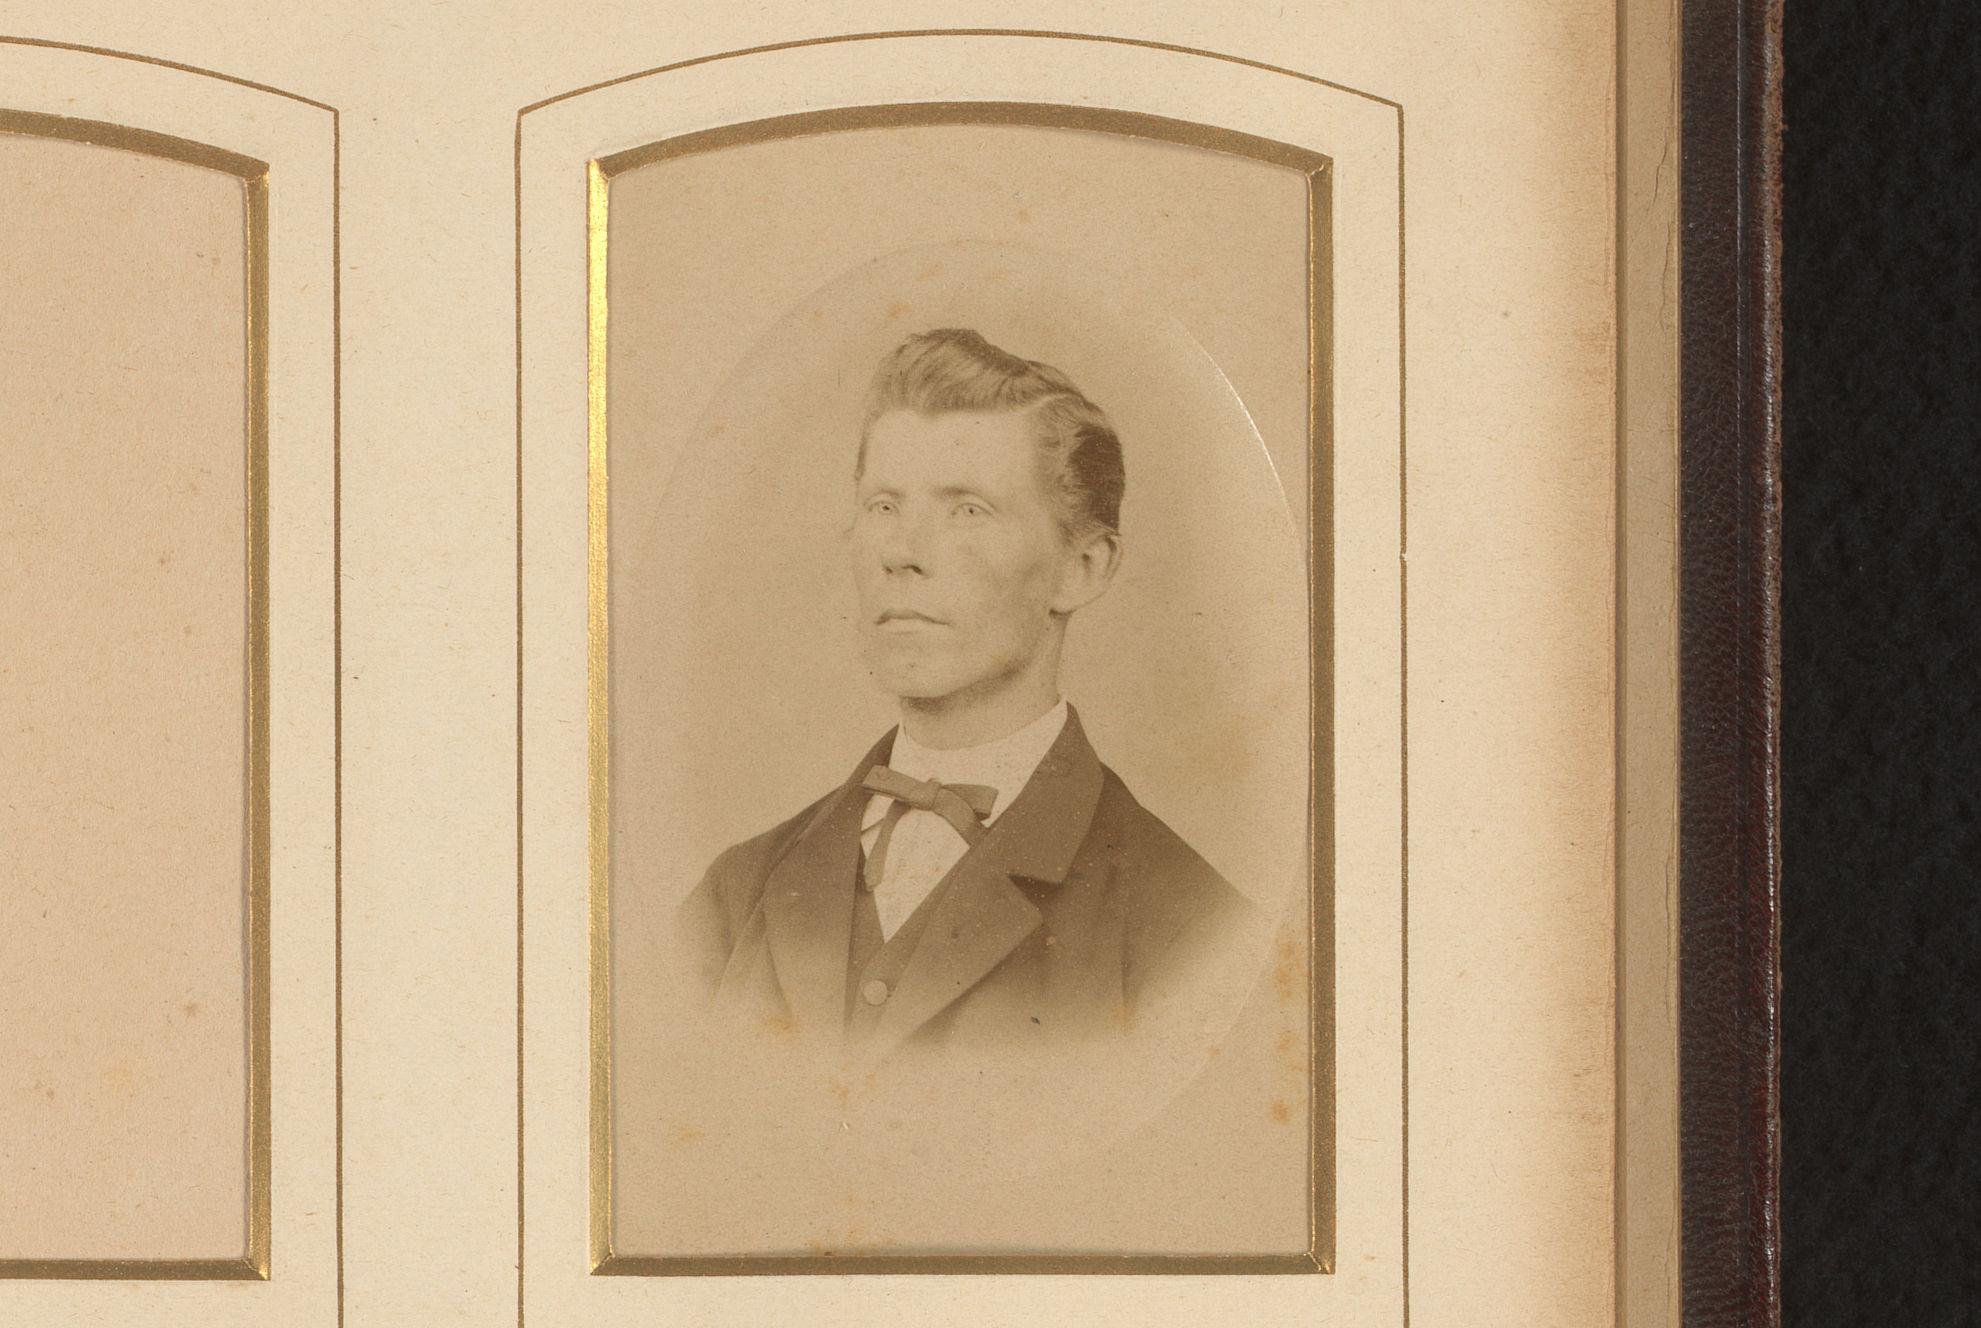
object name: carte de visite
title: Portret van een man met vlinderstrik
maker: joseph swaab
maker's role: fotograaf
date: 1870-1890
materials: cardboard, photographic support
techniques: albumen print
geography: netherlands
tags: historical persons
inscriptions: inscription: ‘Photographische Inrigting/ van/ Joseph Swaab/ PHOTOGRAAF/ EN LEVERANCIER VAN Z.K.H. PRINS HENDRIK/ DER N.D.L.D./ Rotterdam/ Warmoezierstraat bij de Jonker Fransstraa./ Zutphen, buiten de Larenpoort./ Utrecht, Catharijne Singel./ Tiel, buiten de Buursche Barrière./ De platen blijven tot nabestelling bewaard.’